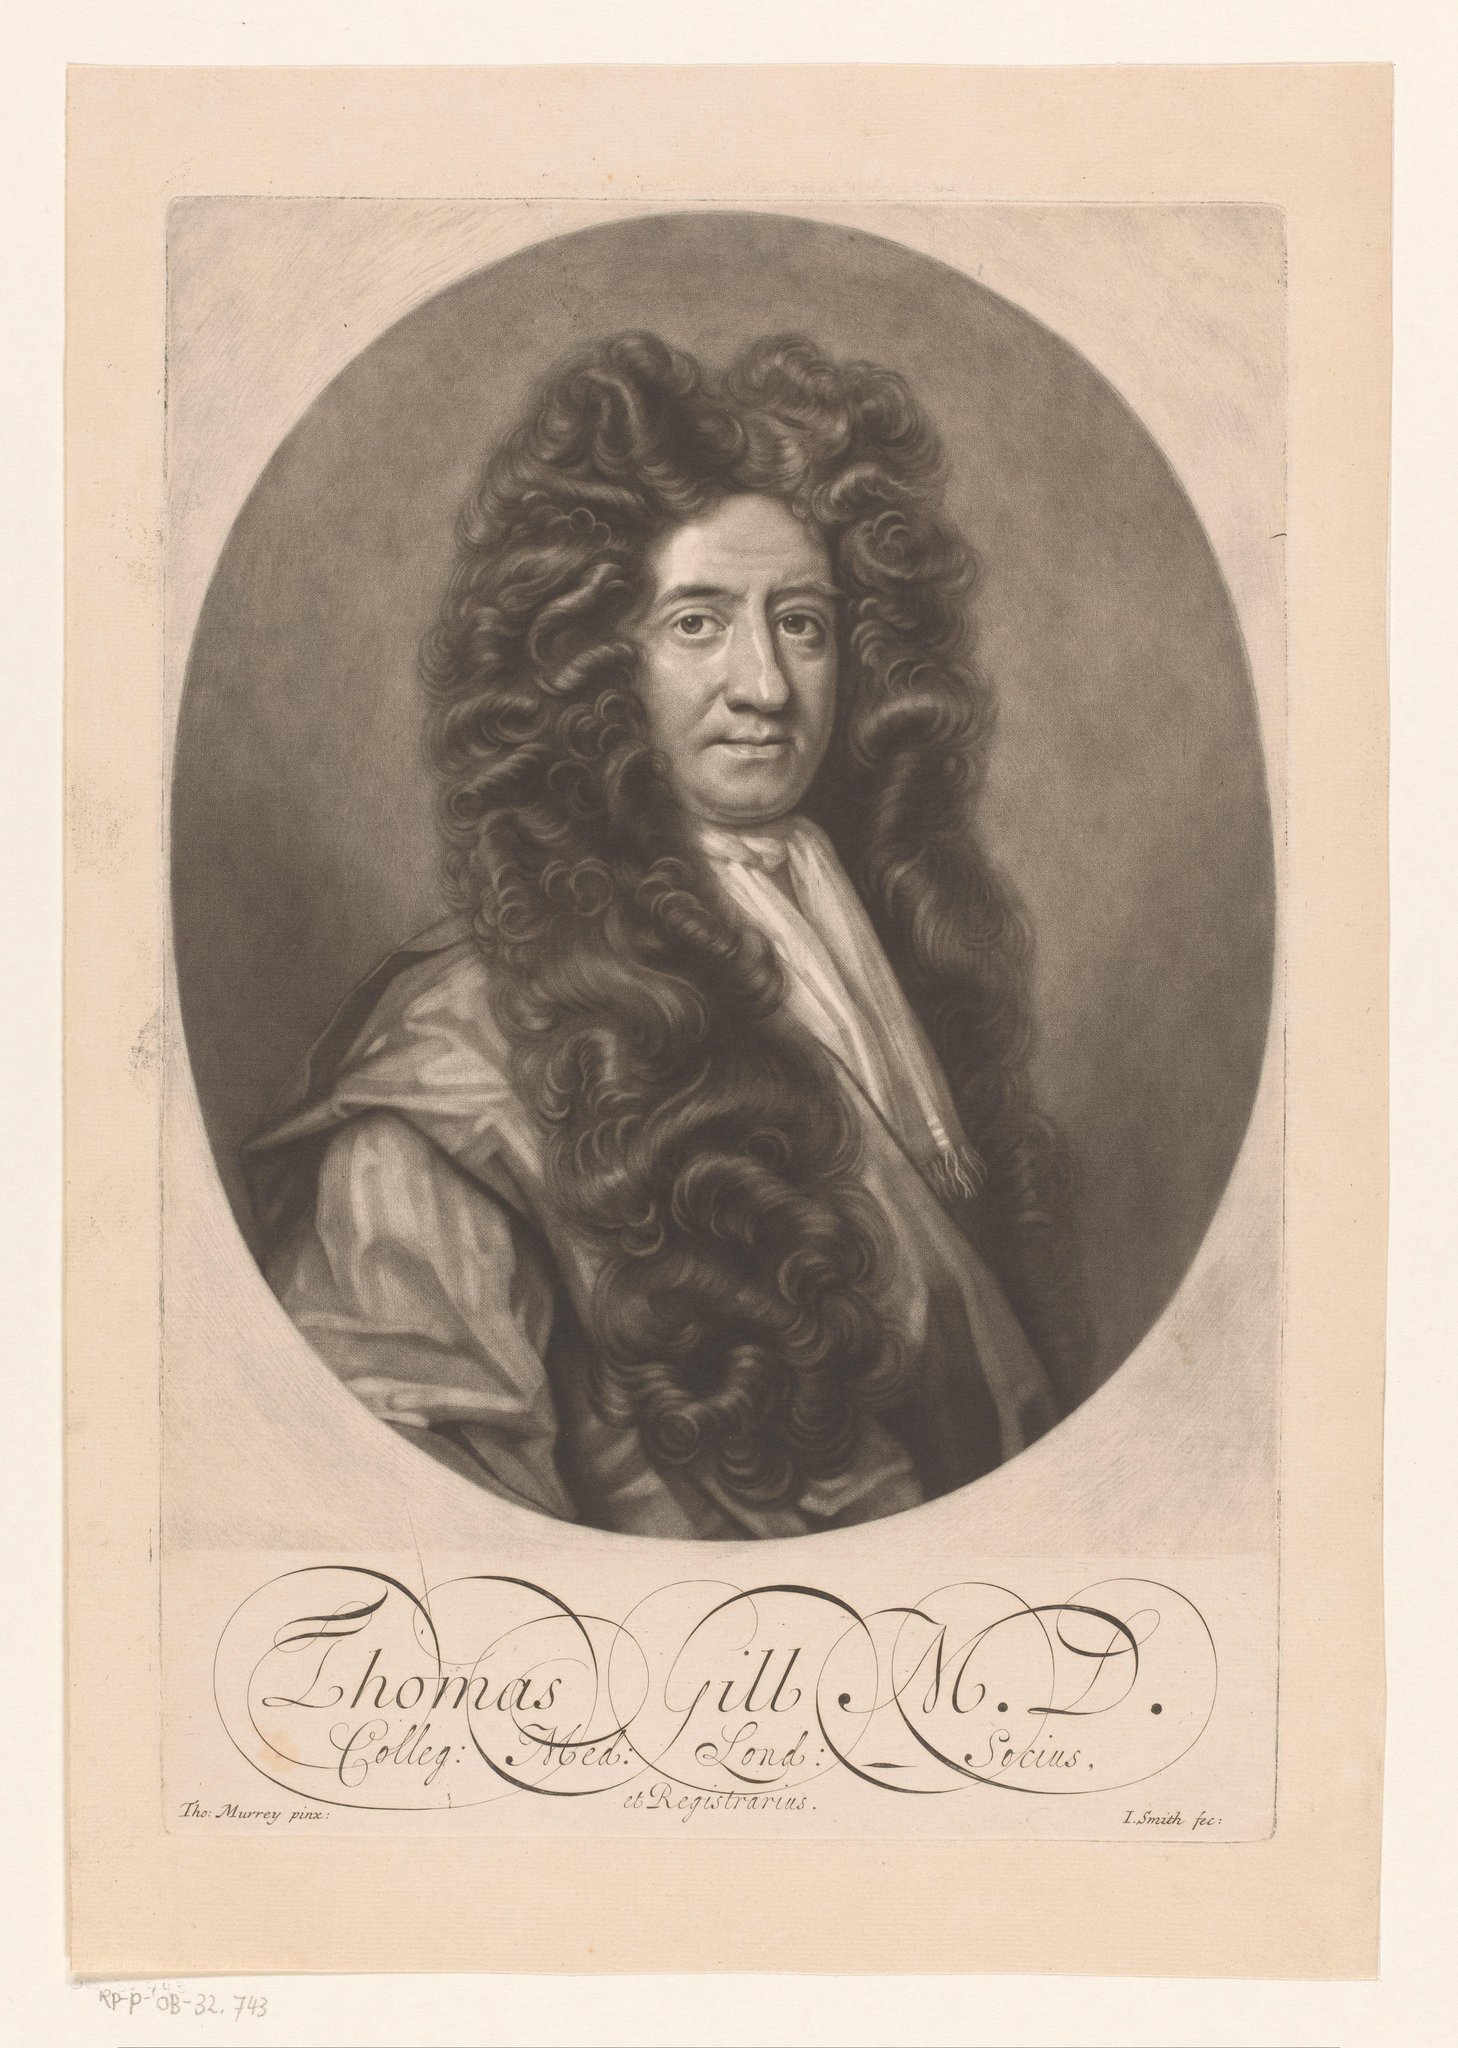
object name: print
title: Portret van Thomas Gill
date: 1662-1742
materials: paper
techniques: mezzotint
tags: historical persons, physician, doctor (+ portrait of scholar, scientist)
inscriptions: collector's mark: Lugt 240